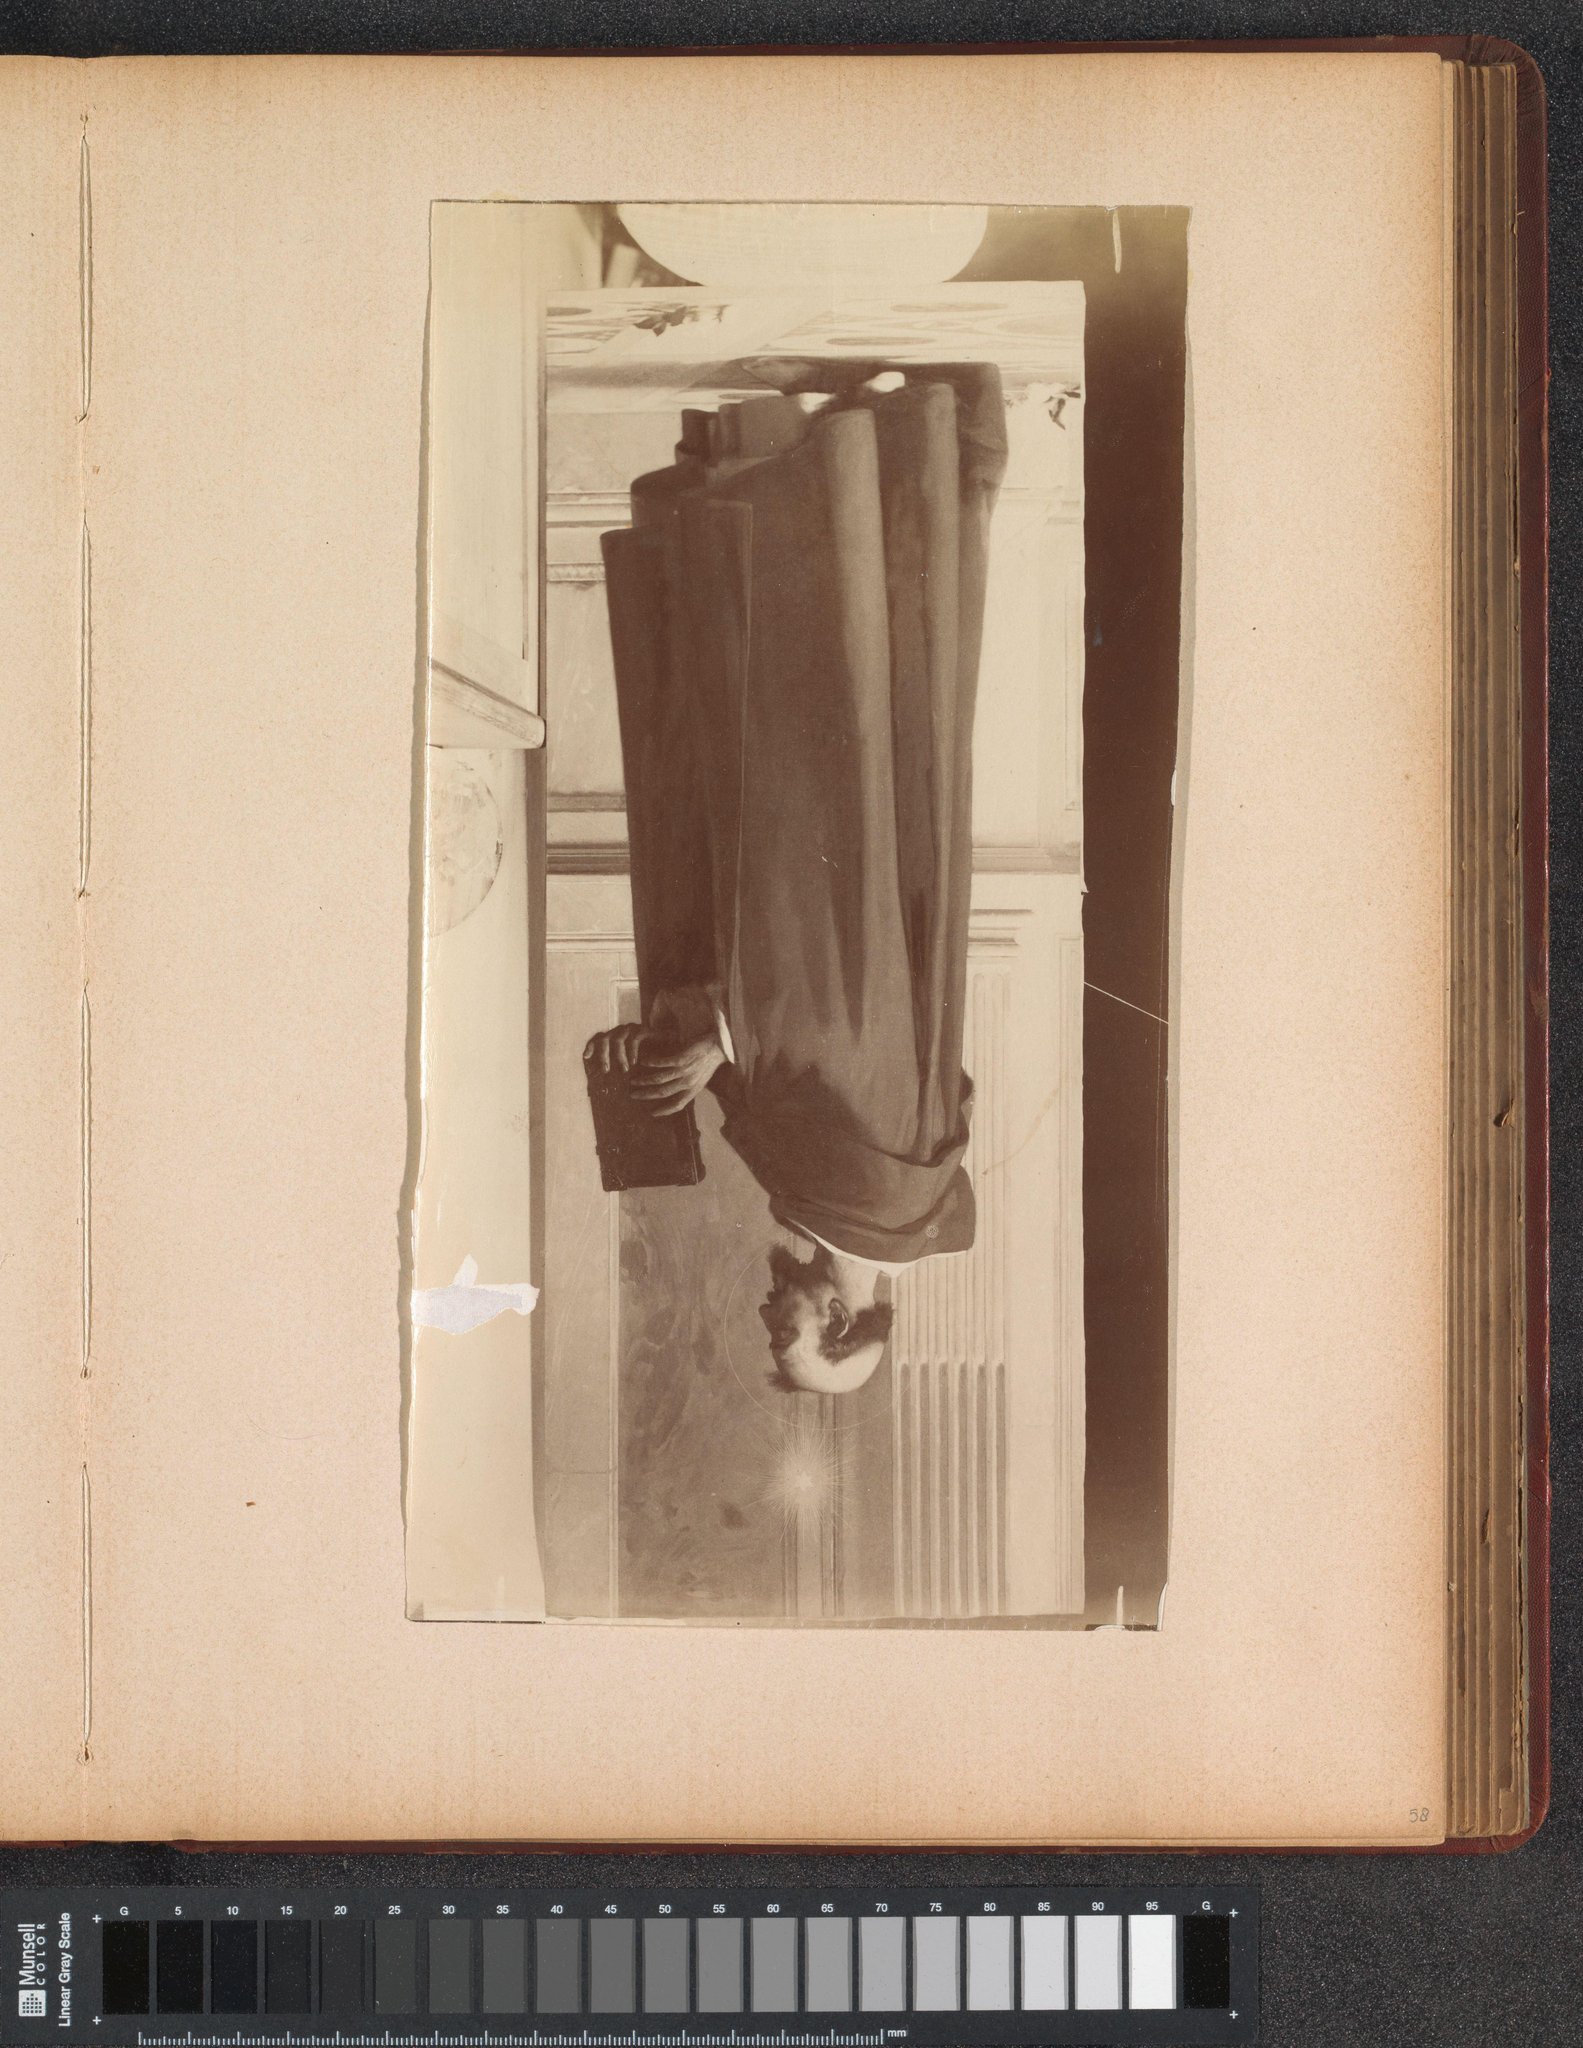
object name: photograph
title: Fotoreproductie van (vermoedelijk) een schilderij van een staande monnik met een boek in de hand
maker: Anonymous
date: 1870-1900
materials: paper, photographic support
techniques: albumen print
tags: monk(s), friar(s)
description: Onderdeel van Reisalbum met foto's van bezienswaardigheden in Italië en Zuid-Frankrijk.